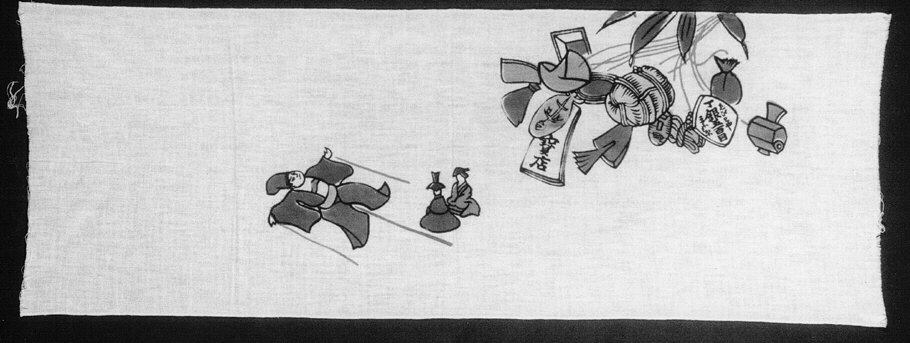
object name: strip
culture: japanese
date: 1901-1950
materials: cotton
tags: toys